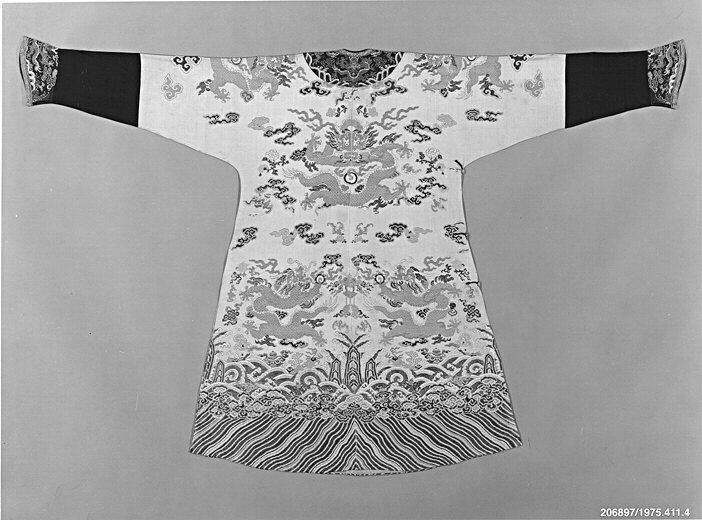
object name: dragon robe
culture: chinese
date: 1701-1800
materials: silk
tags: dragons